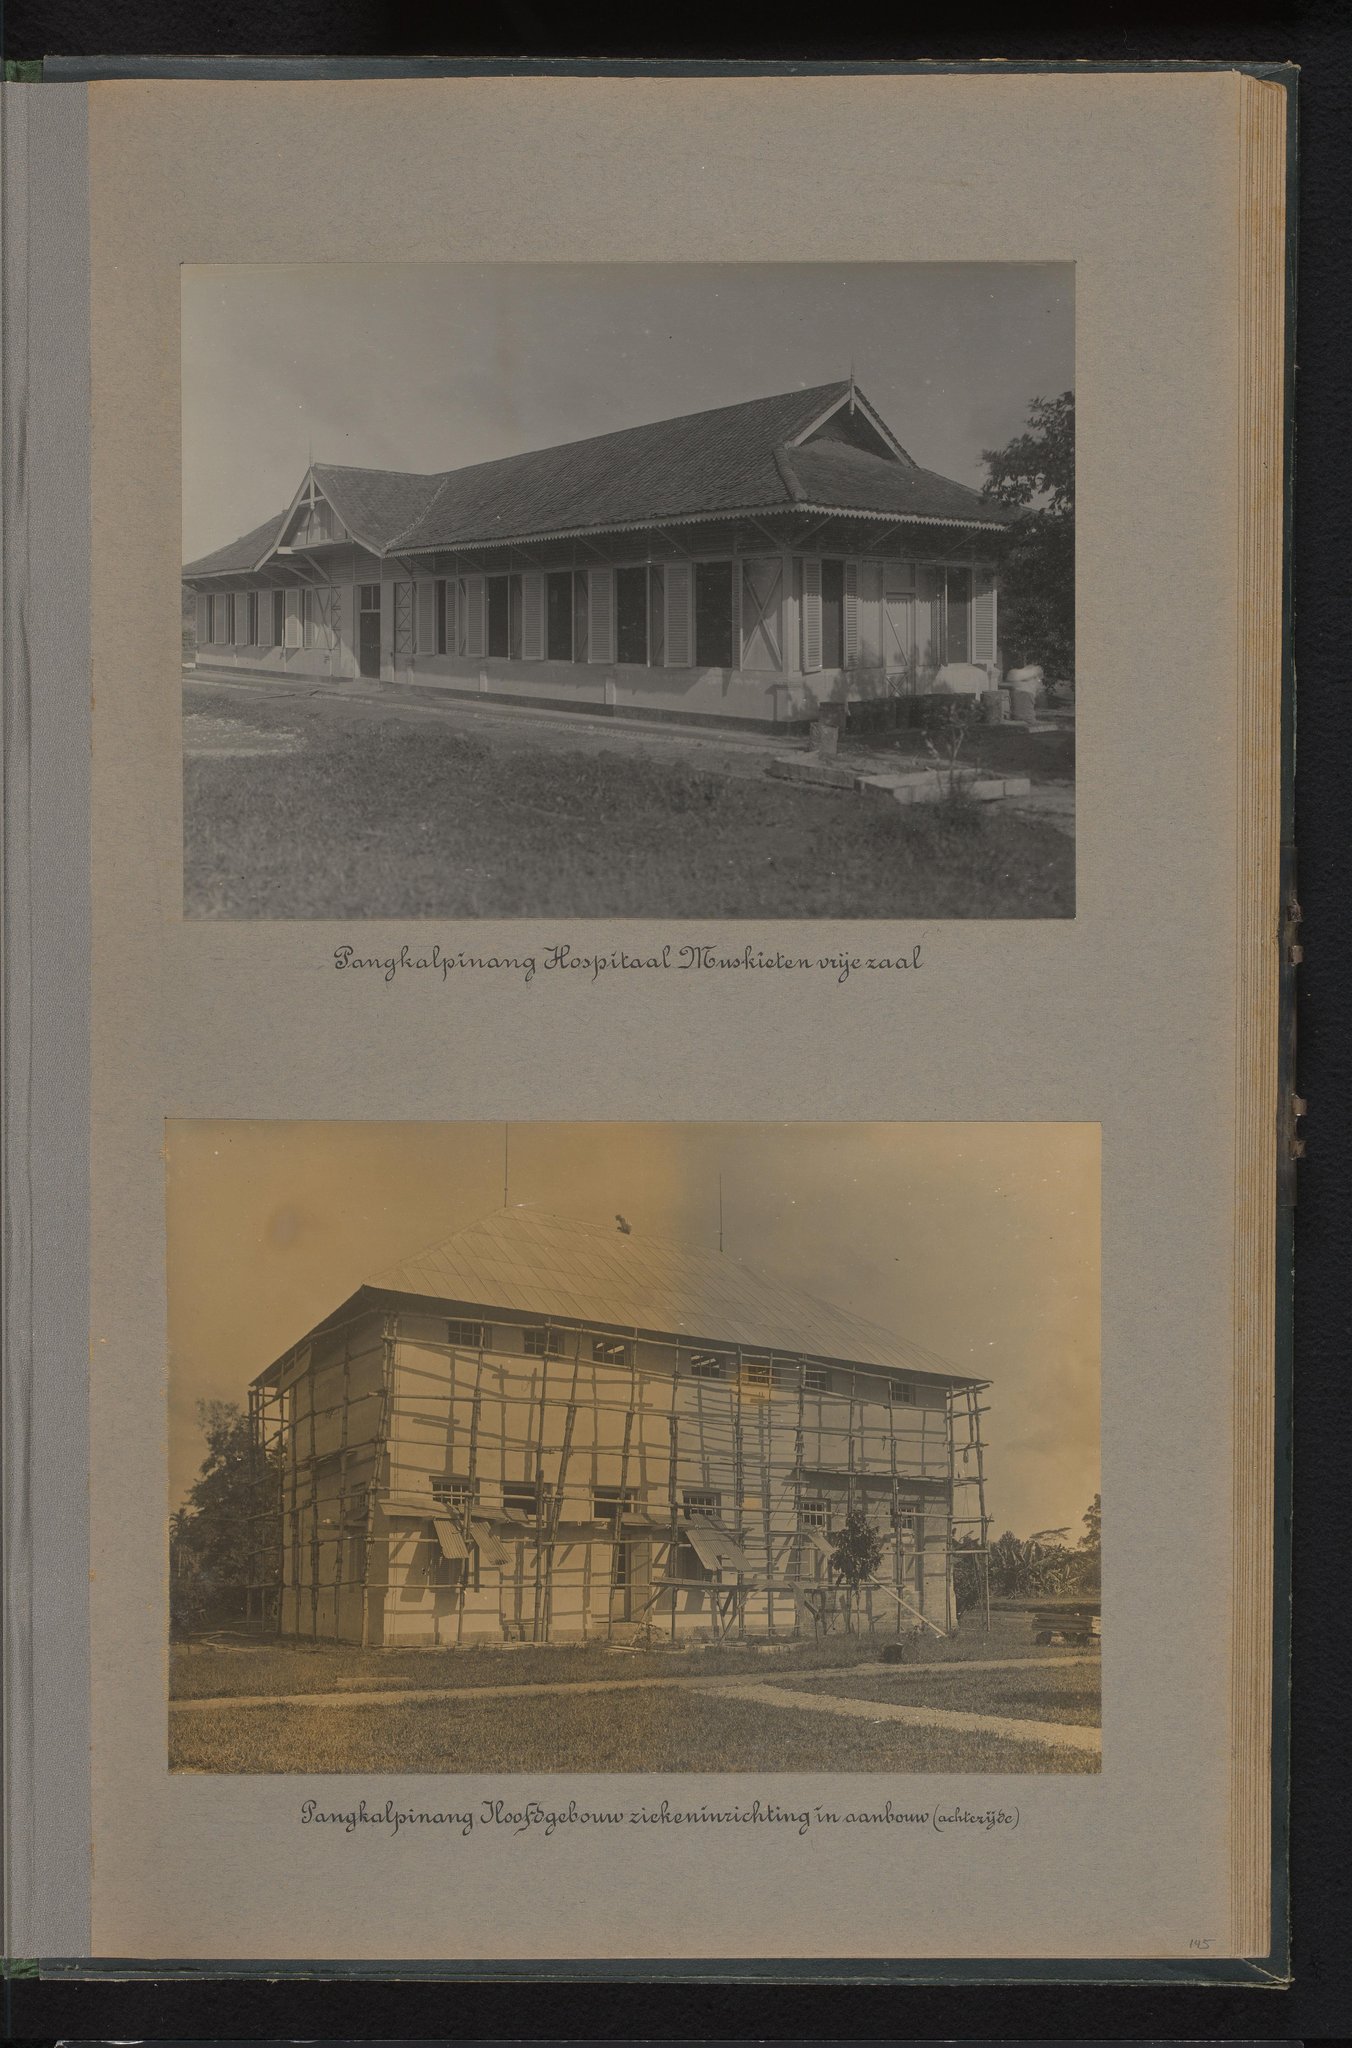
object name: photograph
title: Ziekeninrichting te Pangkalpinang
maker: Anonymous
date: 1914-1919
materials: cardboard, photographic support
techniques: gelatin silver print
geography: bangka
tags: robert julius boers, colonial system, mining, making the overground structures (~ building activities), hospital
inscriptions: inscription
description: Albumblad met 2 foto's van de muskietenvrije zaal van het hospitaal en van het hoofdgebouw van de ziekeninrichting in aanbouw, van de mijnbouwonderneming te Pangkalpinang. Onderdeel van het fotoalbum aangeboden aan Robert Julius Boers bij zijn vertrek naar Nederland in 1919 door het personeel van de Banka-tinwinning.